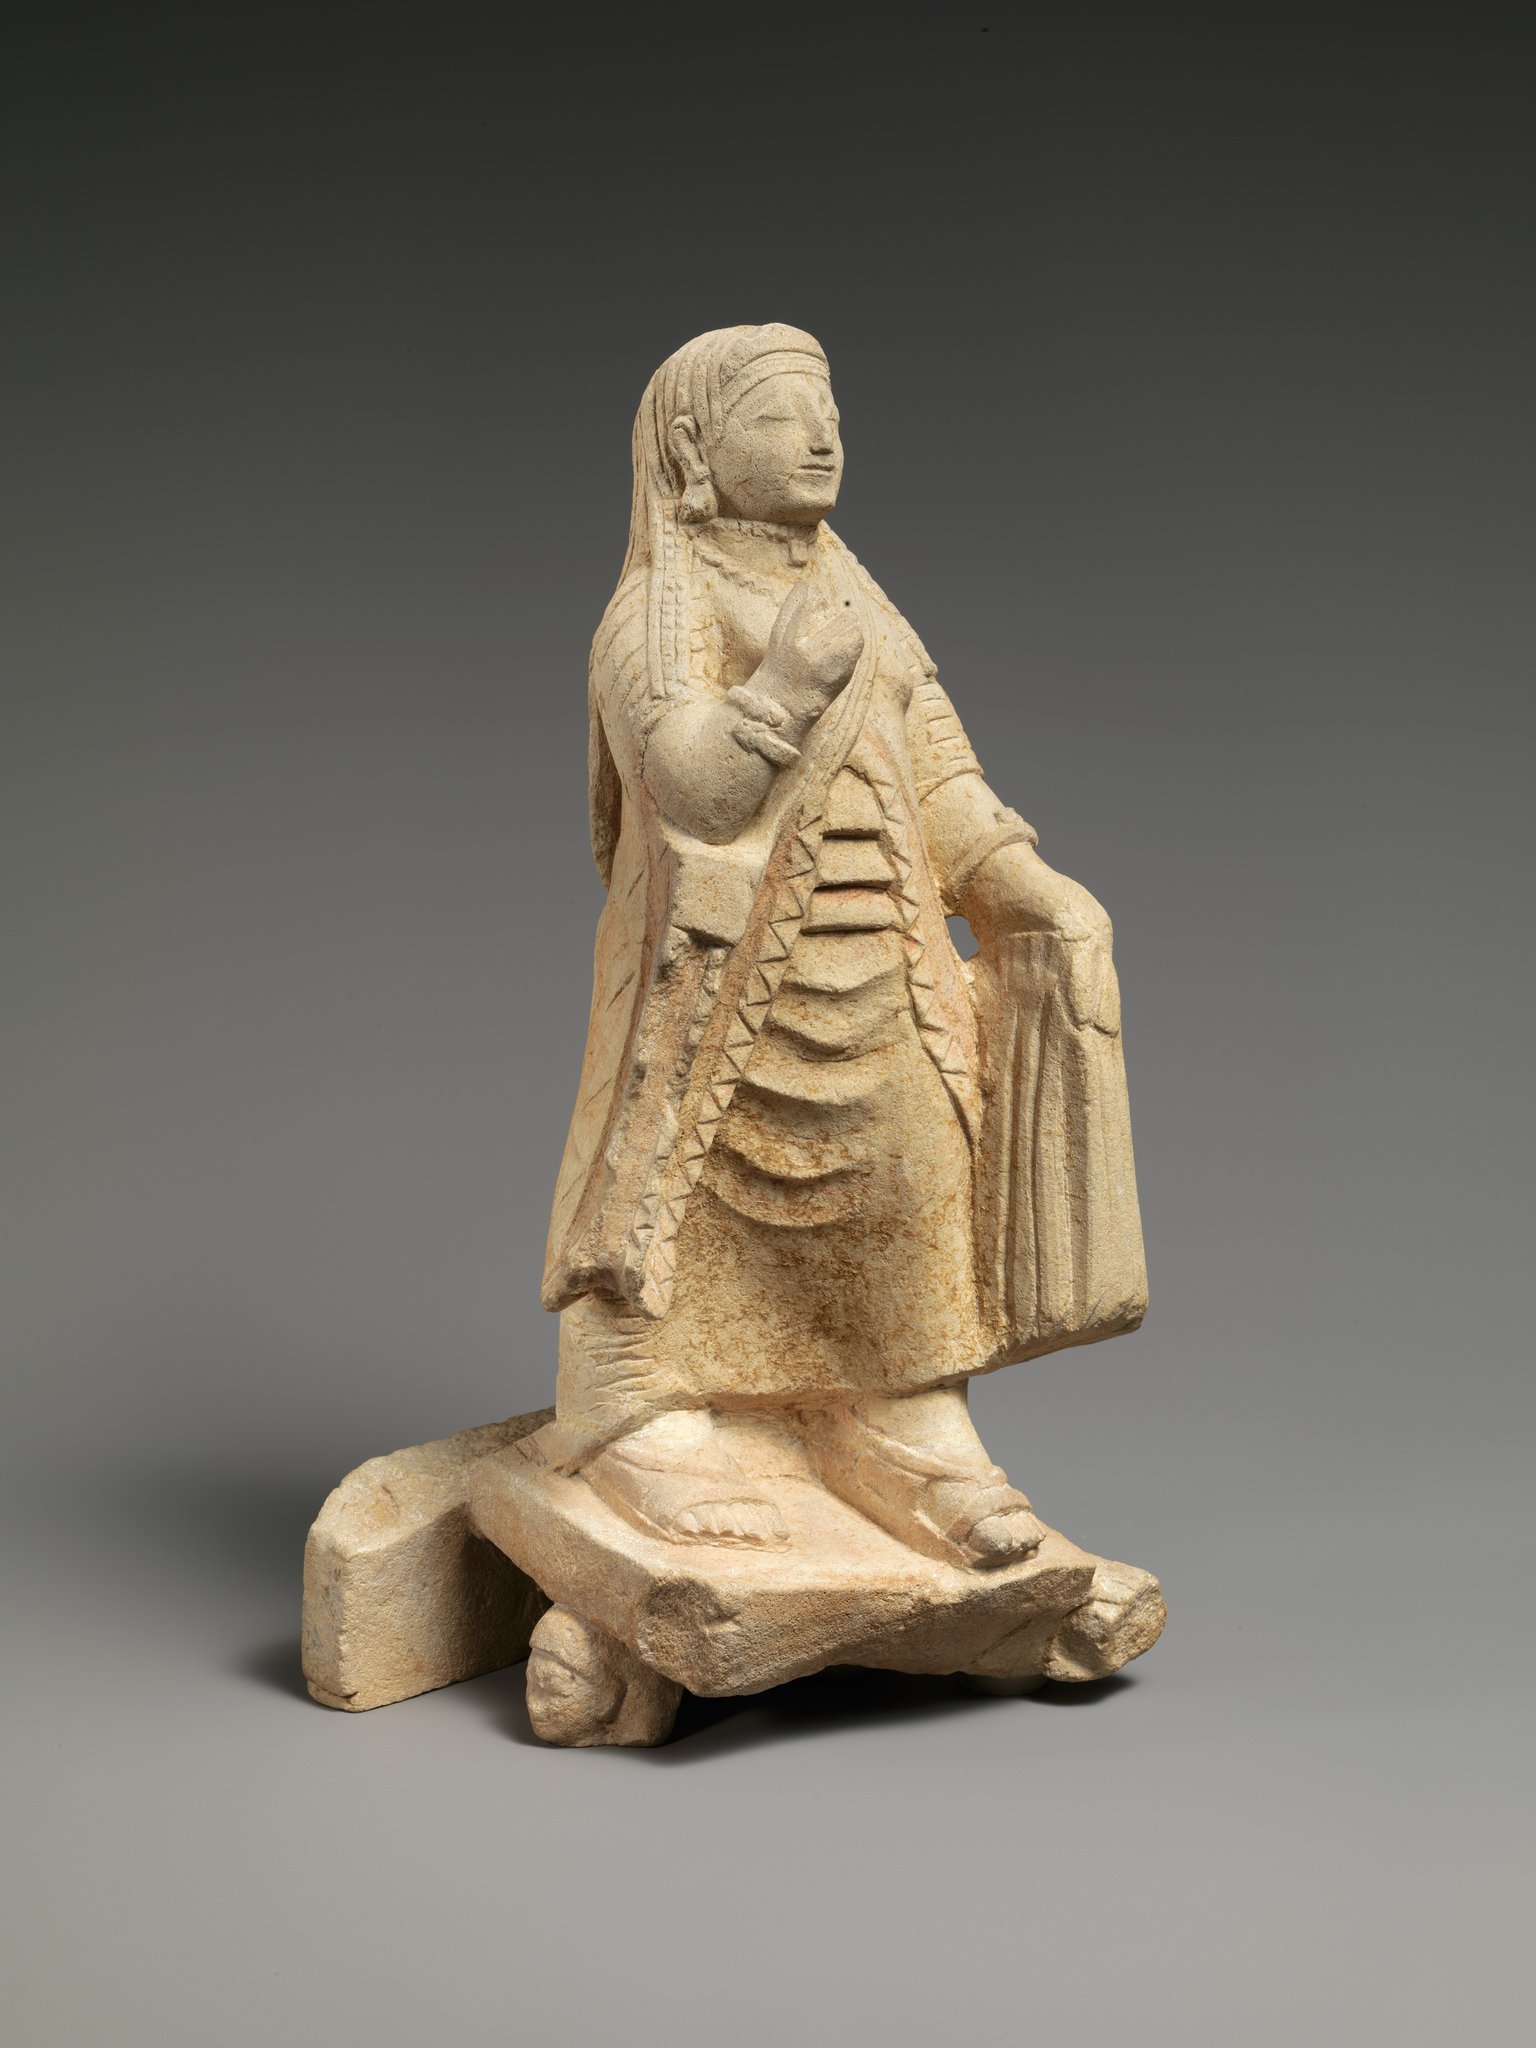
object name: statuette of a woman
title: Limestone figure of a woman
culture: cypriot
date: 534-501 BCE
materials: limestone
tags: diadems,earrings,necklaces,women